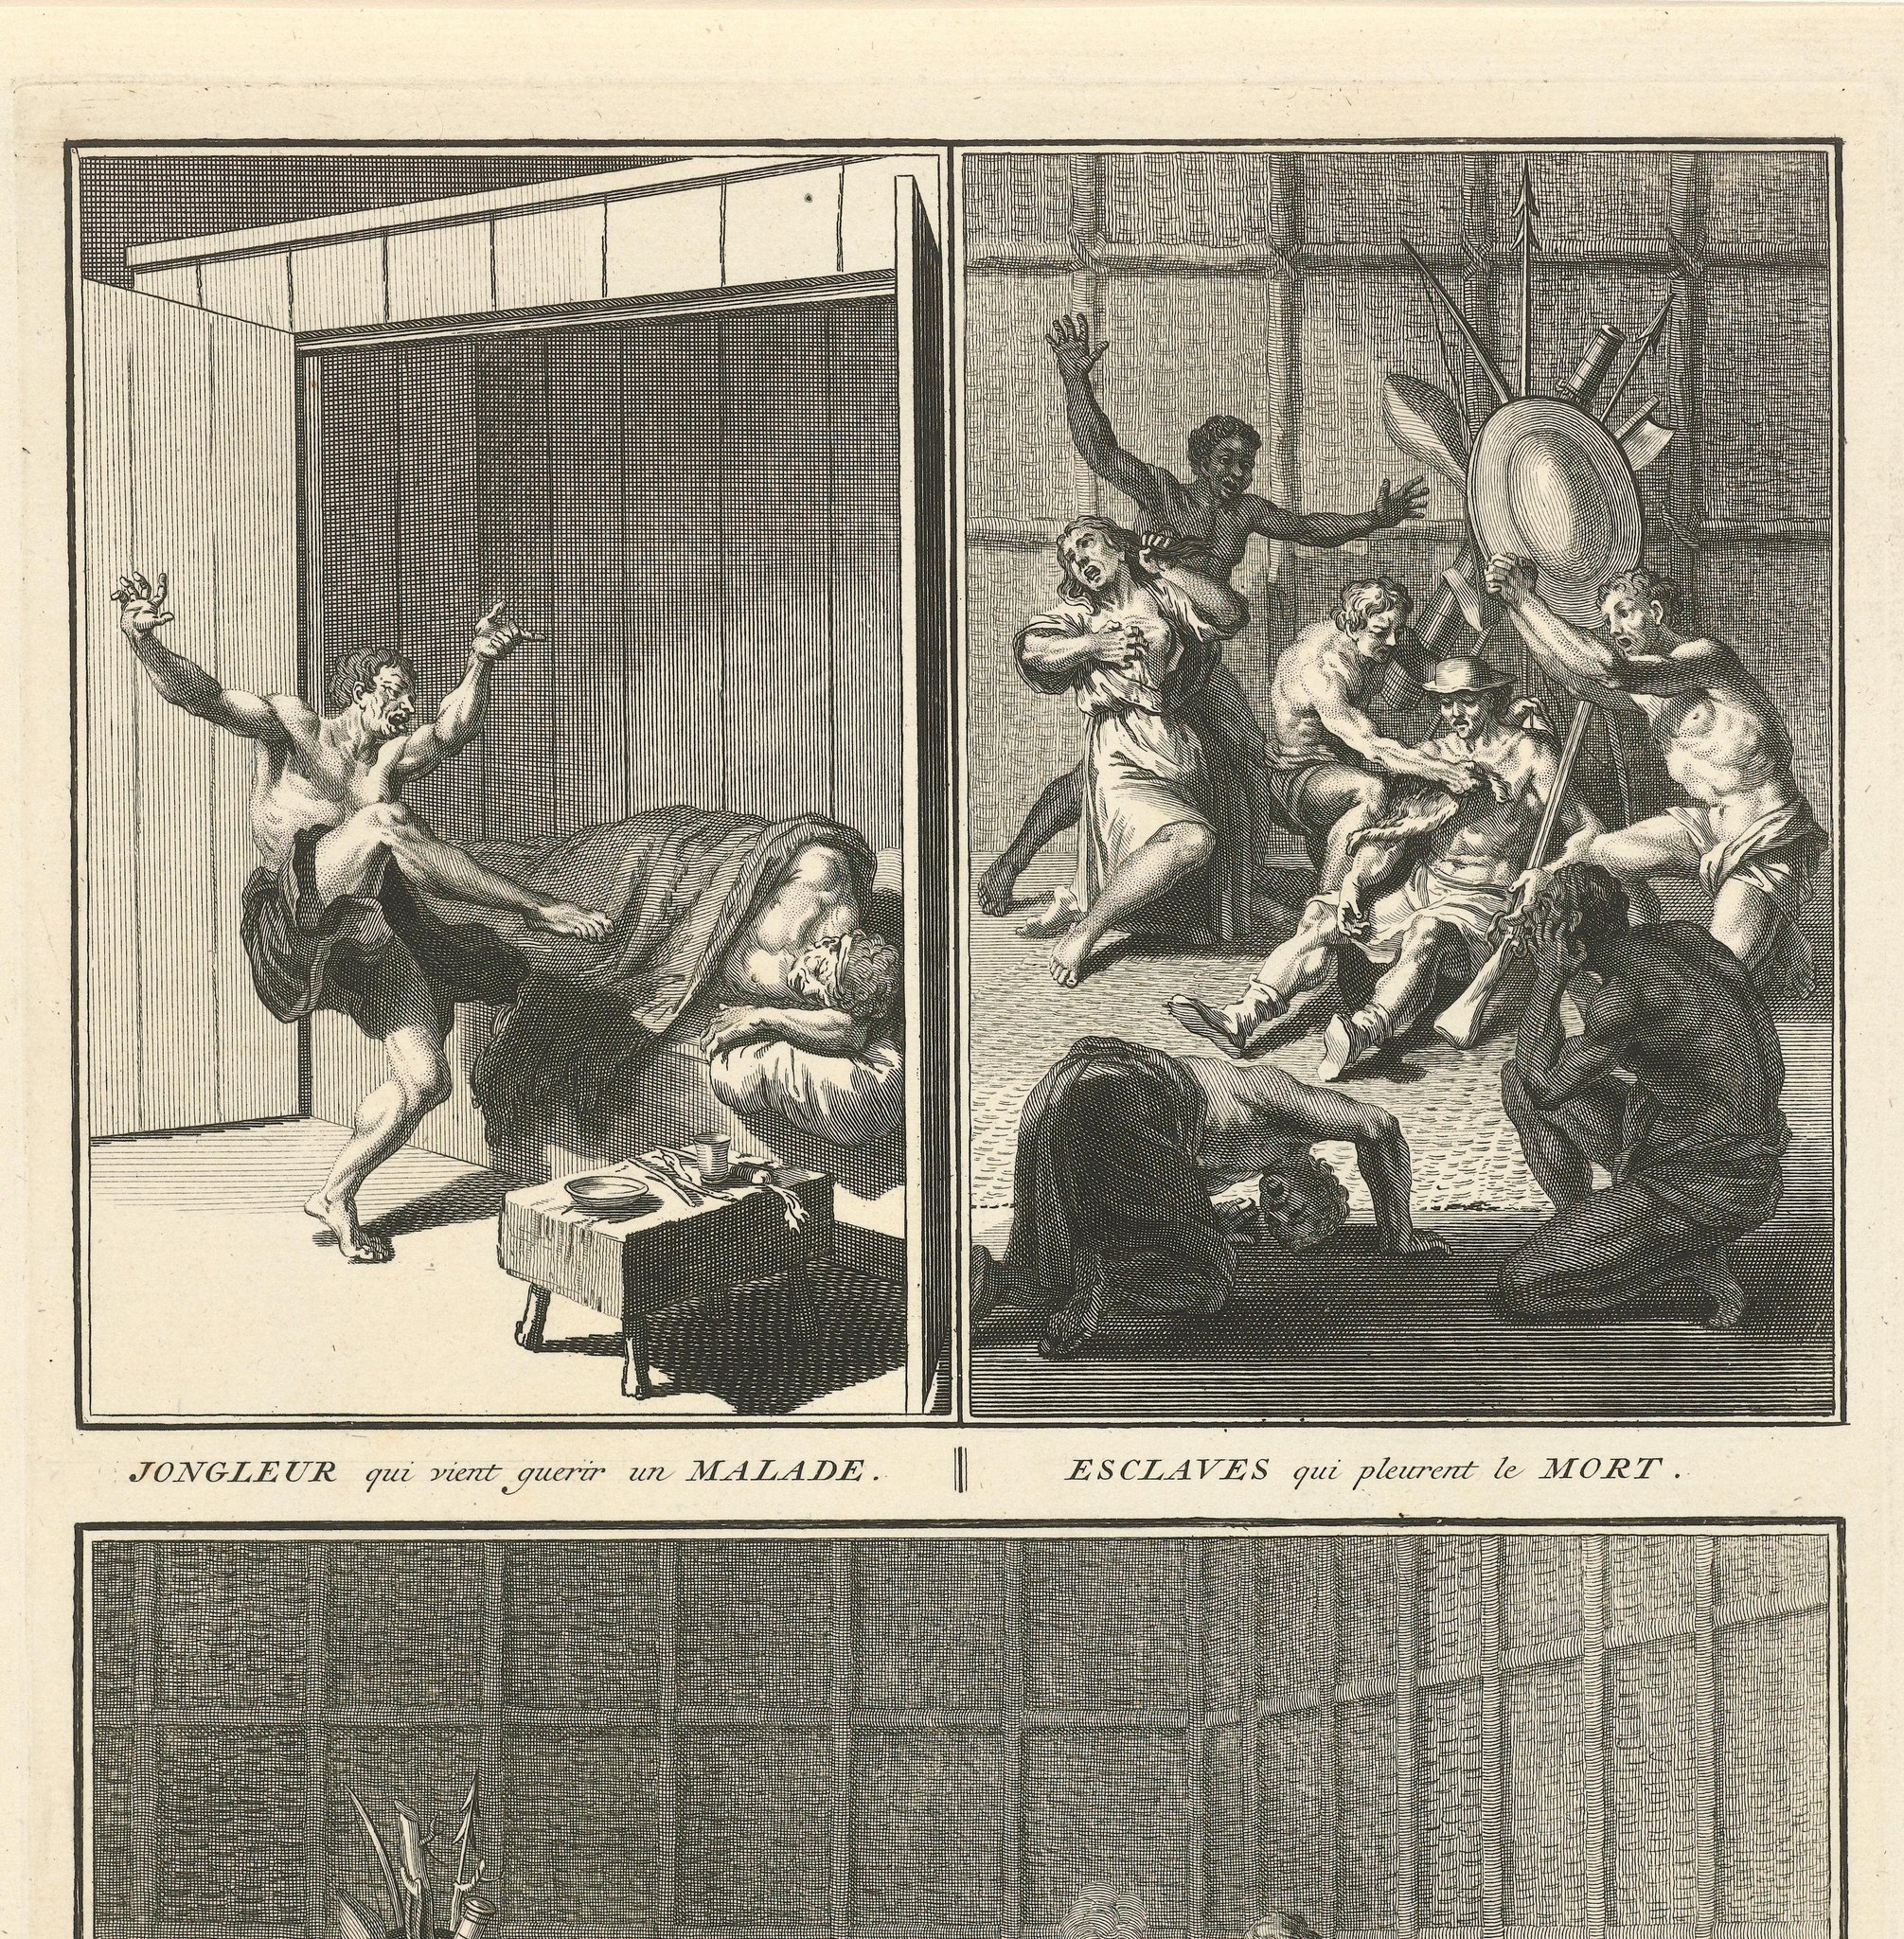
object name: print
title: Les parens demandent au défunt la cause de sa mort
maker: bernard picart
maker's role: draughtsman, print maker, publisher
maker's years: 1673-1733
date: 1723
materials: paper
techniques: engraving, etching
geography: amsterdam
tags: ritual practices ~ american indian religions, ritual practices ~ stadia of human life (american indian religions), ritual practices ~ death and burial (american indian religions), indigenous peoples of north america, slavery; serfs and enslaved persons, diseases, canada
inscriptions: collector's mark: Lugt 2228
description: Prent ook gebruikt in: Picart, Bernard. Naaukeurige beschryving der uitwendige godtsdienst-plichten, kerk-zeden en gewoontens van alle volkeren der waereldt, deel III. [Vertaald in het Nederlands door] Moubach, Abraham. Den Haag, Amsterdam, Rotterdam: Rutgert Alberts, Hermannus Uytwerf, Jan Daniel Beman, Isaac van der Kloot, 1727-1738. Prent ook gebruikt als illustratie in: Picart, Bernard. Cérémonies et coutumes religieuses de tous les peuples du monde: représentées par des figures, deel III. Amsterdam: Jean Frédéric Bernard, 1723-1743.